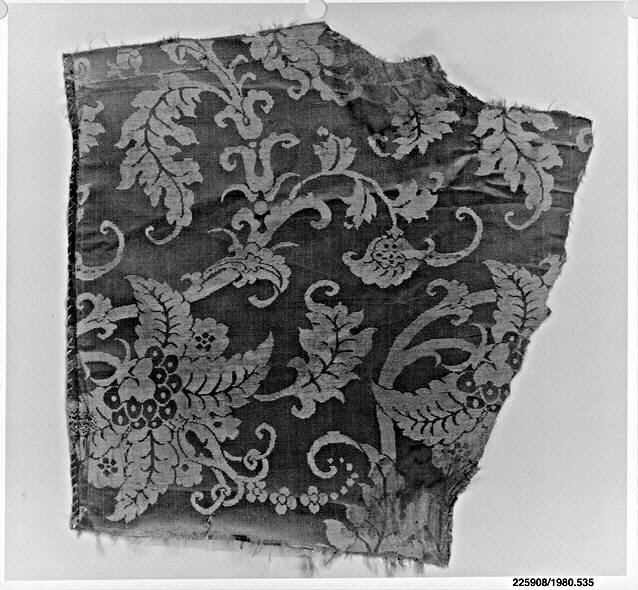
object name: piece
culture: chinese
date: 1701-1750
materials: silk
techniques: damask, weave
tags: flowers,leaves